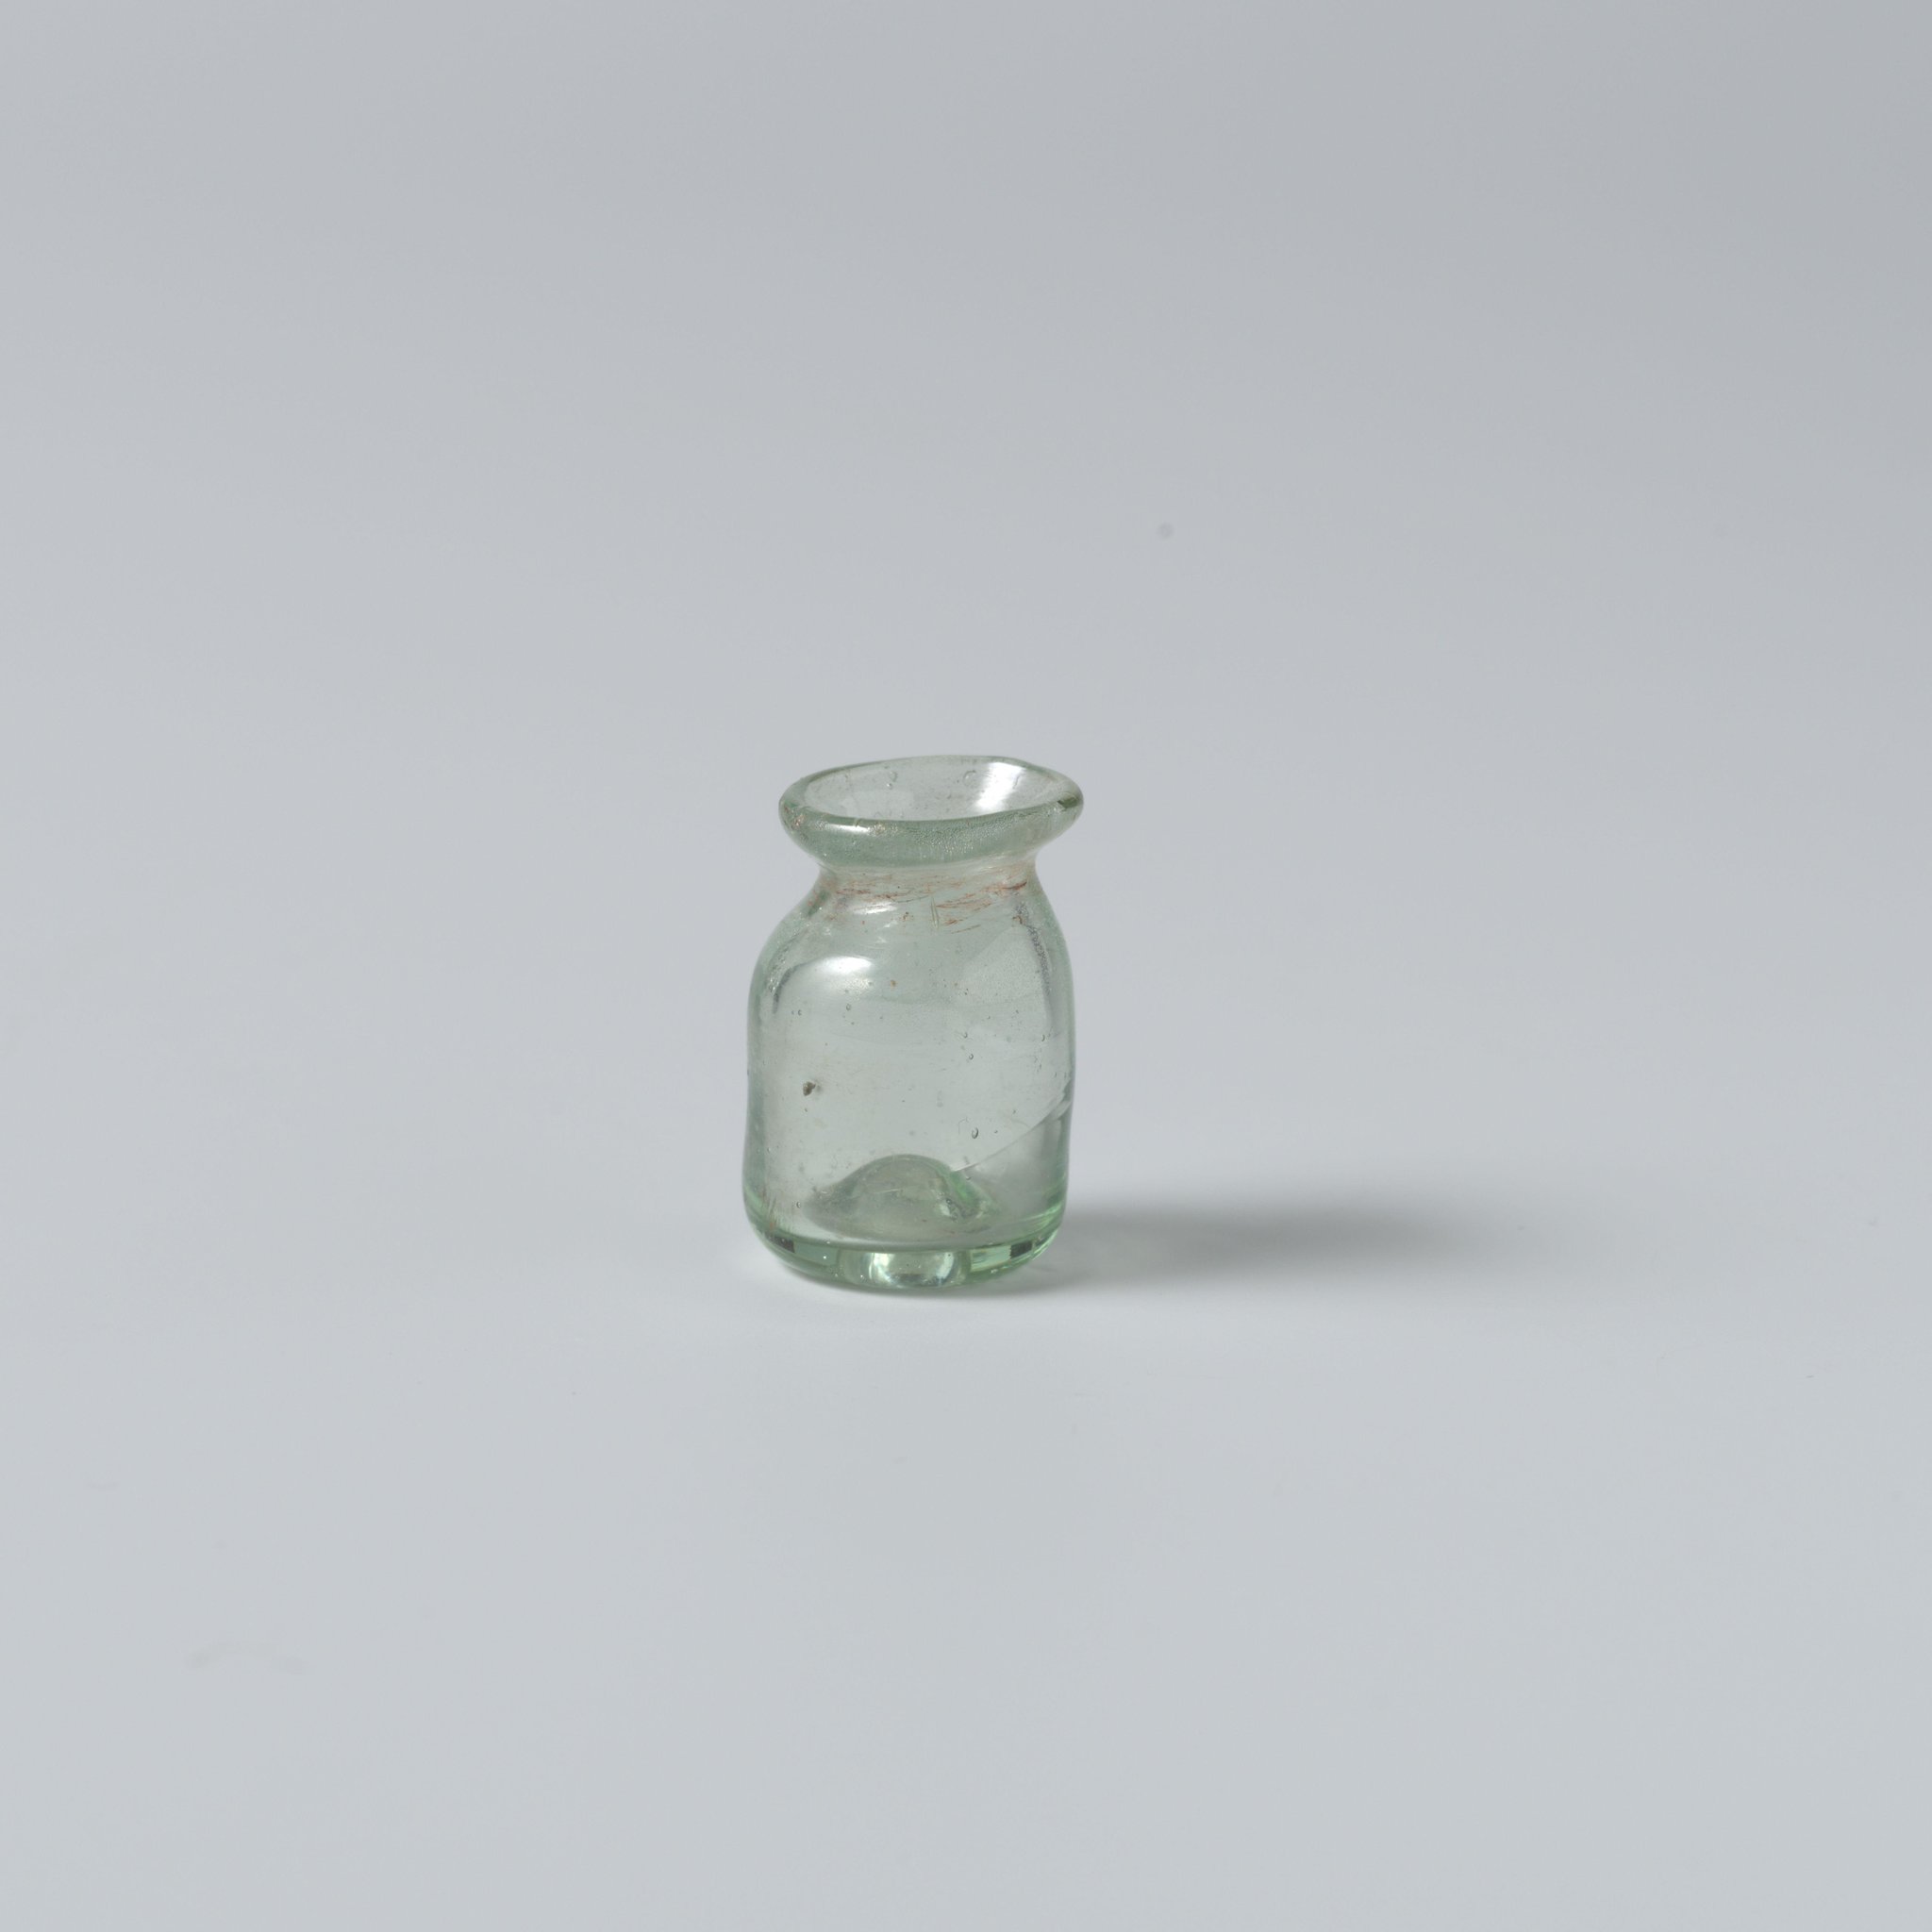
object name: voorraadfles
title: Voorraadfles, cilindervormig, met ingestoken ziel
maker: Anonymous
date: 1700-1799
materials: glass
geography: netherlands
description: Voorraadfles van helder groen glas, cilindervormig, met ingestoken ziel en hals met wijduitstaande rand.